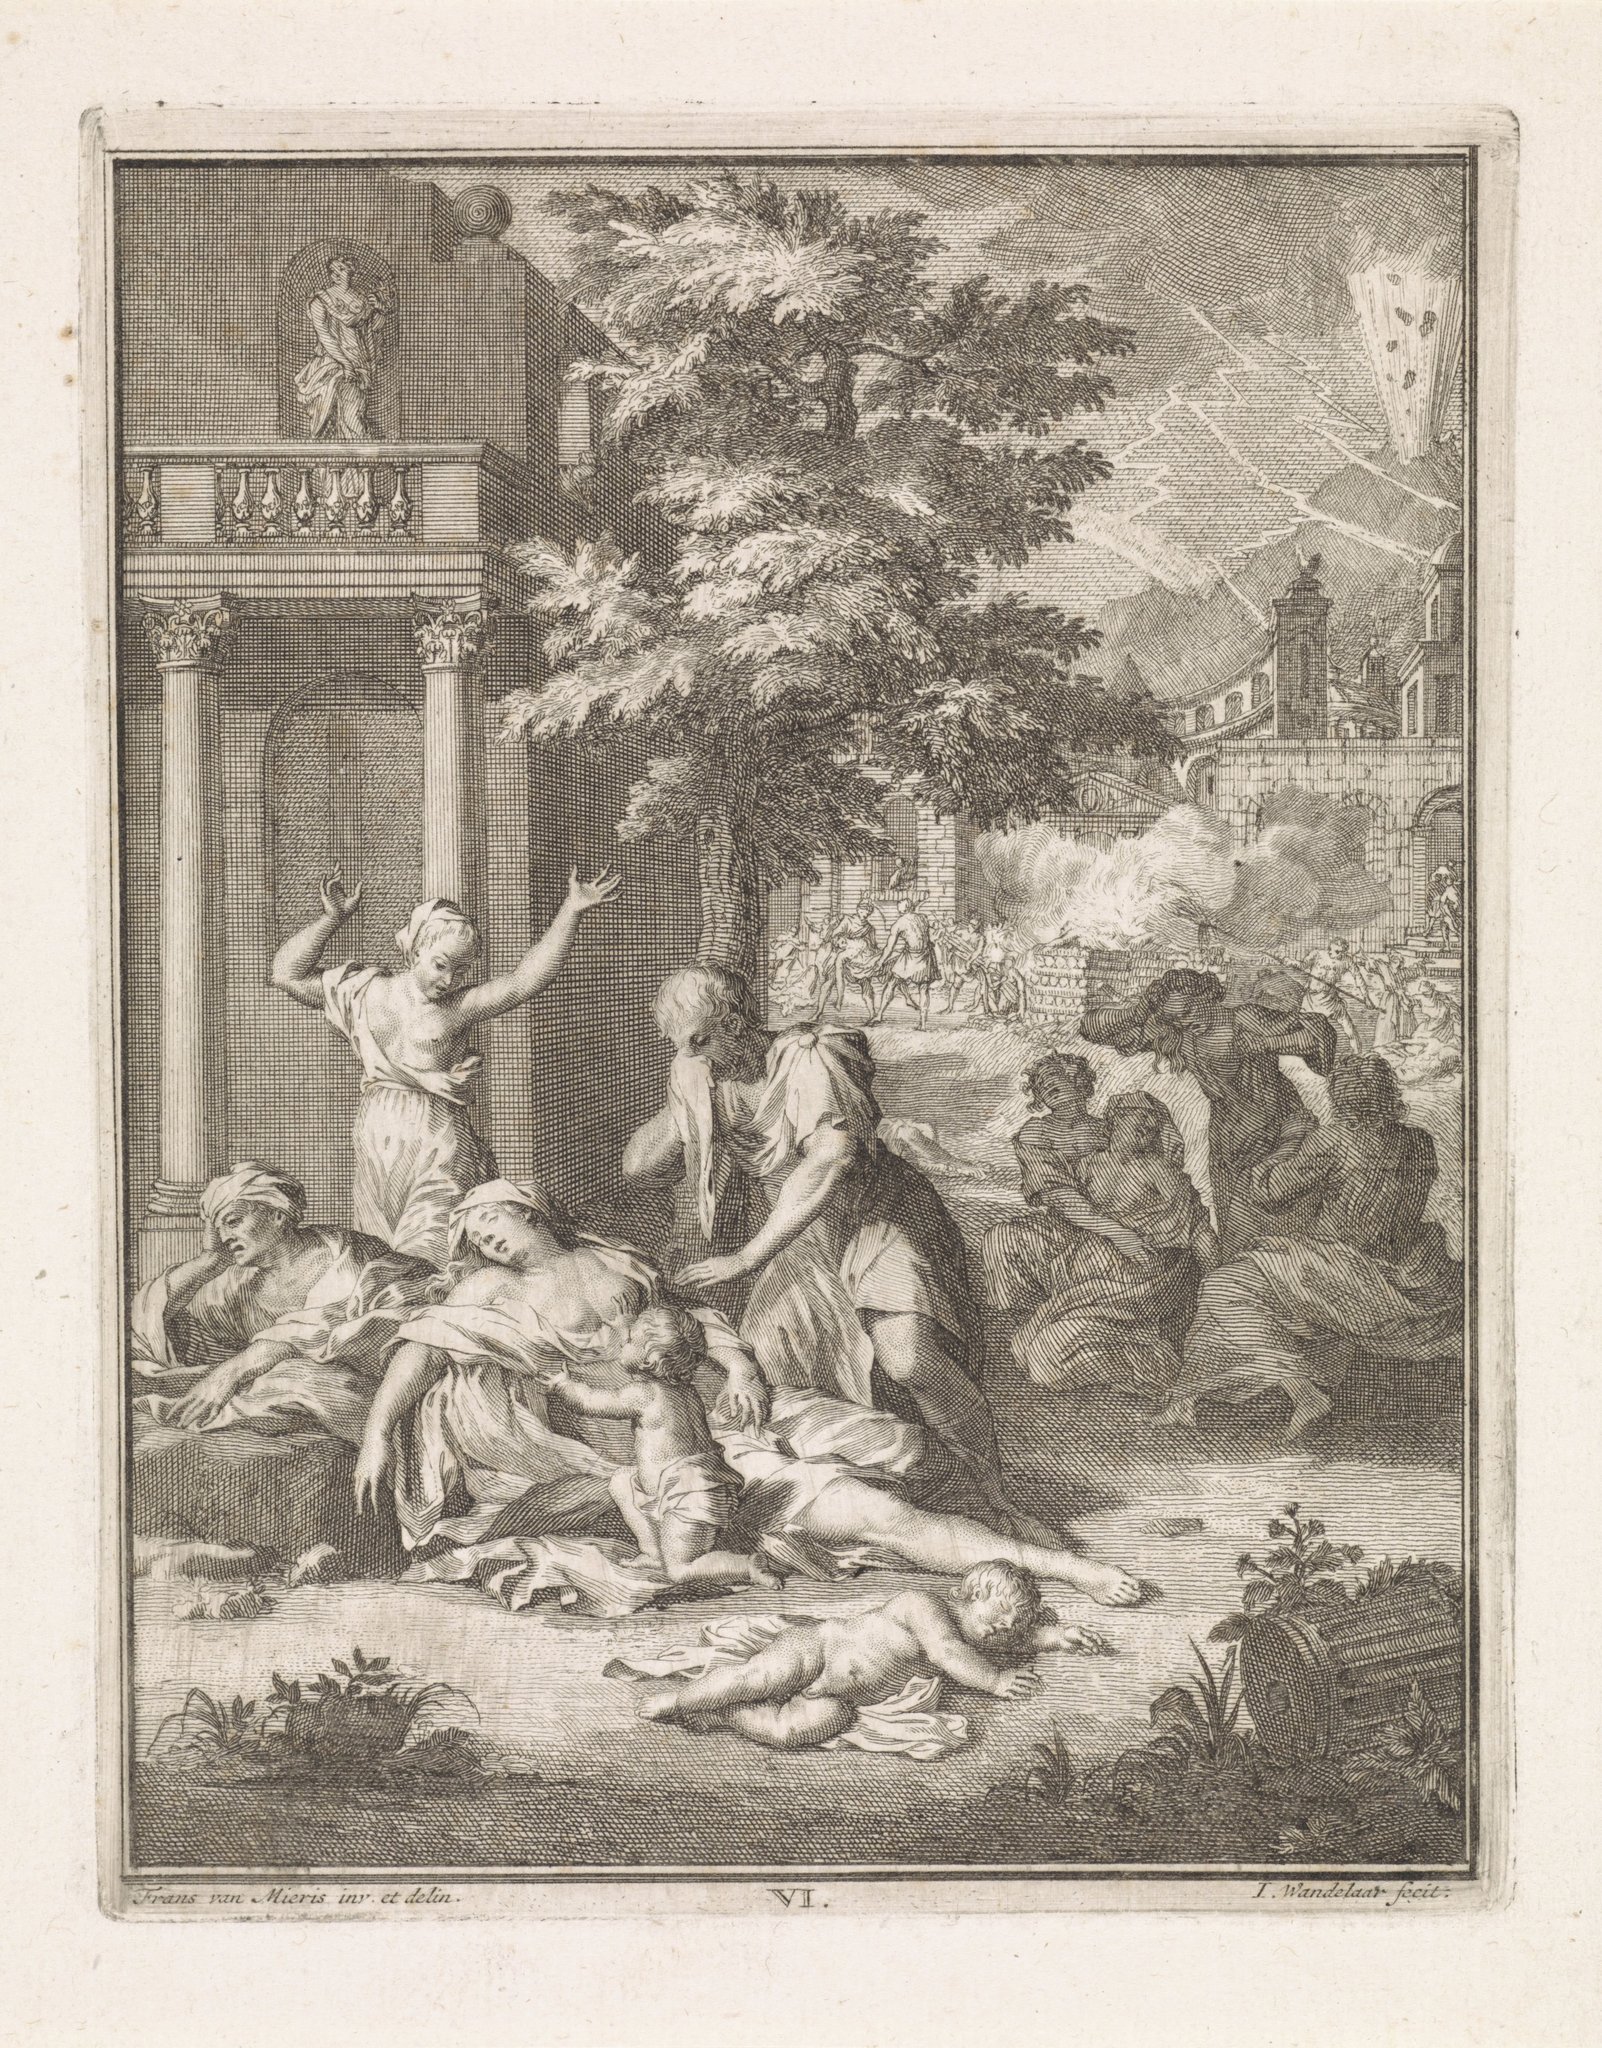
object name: print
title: Gezicht op een verwoeste stad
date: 1725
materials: paper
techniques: engraving, etching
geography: northern netherlands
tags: death caused by effects of natural surroundings, especially natural catastrophes, lightning, flash of lightning, thunderbolt, eruption (of volcano)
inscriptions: collector's mark: Lugt 240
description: Groepen mannen en vrouwen staan in paniek bij elkaar nadat hun stad is getroffen door natuurgeweld. Op de voorgrond treurt een man bij zijn dode vrouw en kind. Op de achtergrond zijn gebouwen ingestort. Een vulkaan is uitgebarsten en de lava spuit eruit. De lucht is gevuld met bliksemschichten. Genummerd midden onder: VI.